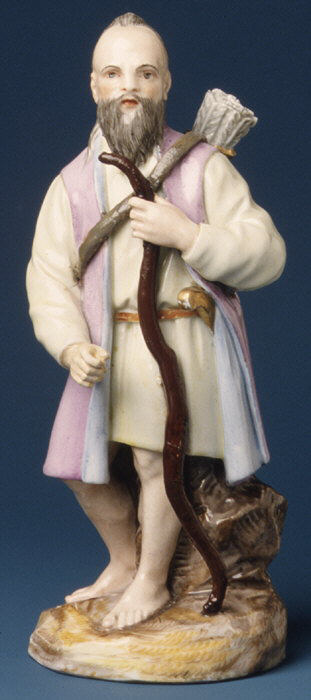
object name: figure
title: Kurile Man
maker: imperial porcelain manufactory, st. petersburg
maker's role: manufactory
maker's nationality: russian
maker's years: 1744-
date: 1780-1800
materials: hard paste porcelain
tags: bow and arrow,men